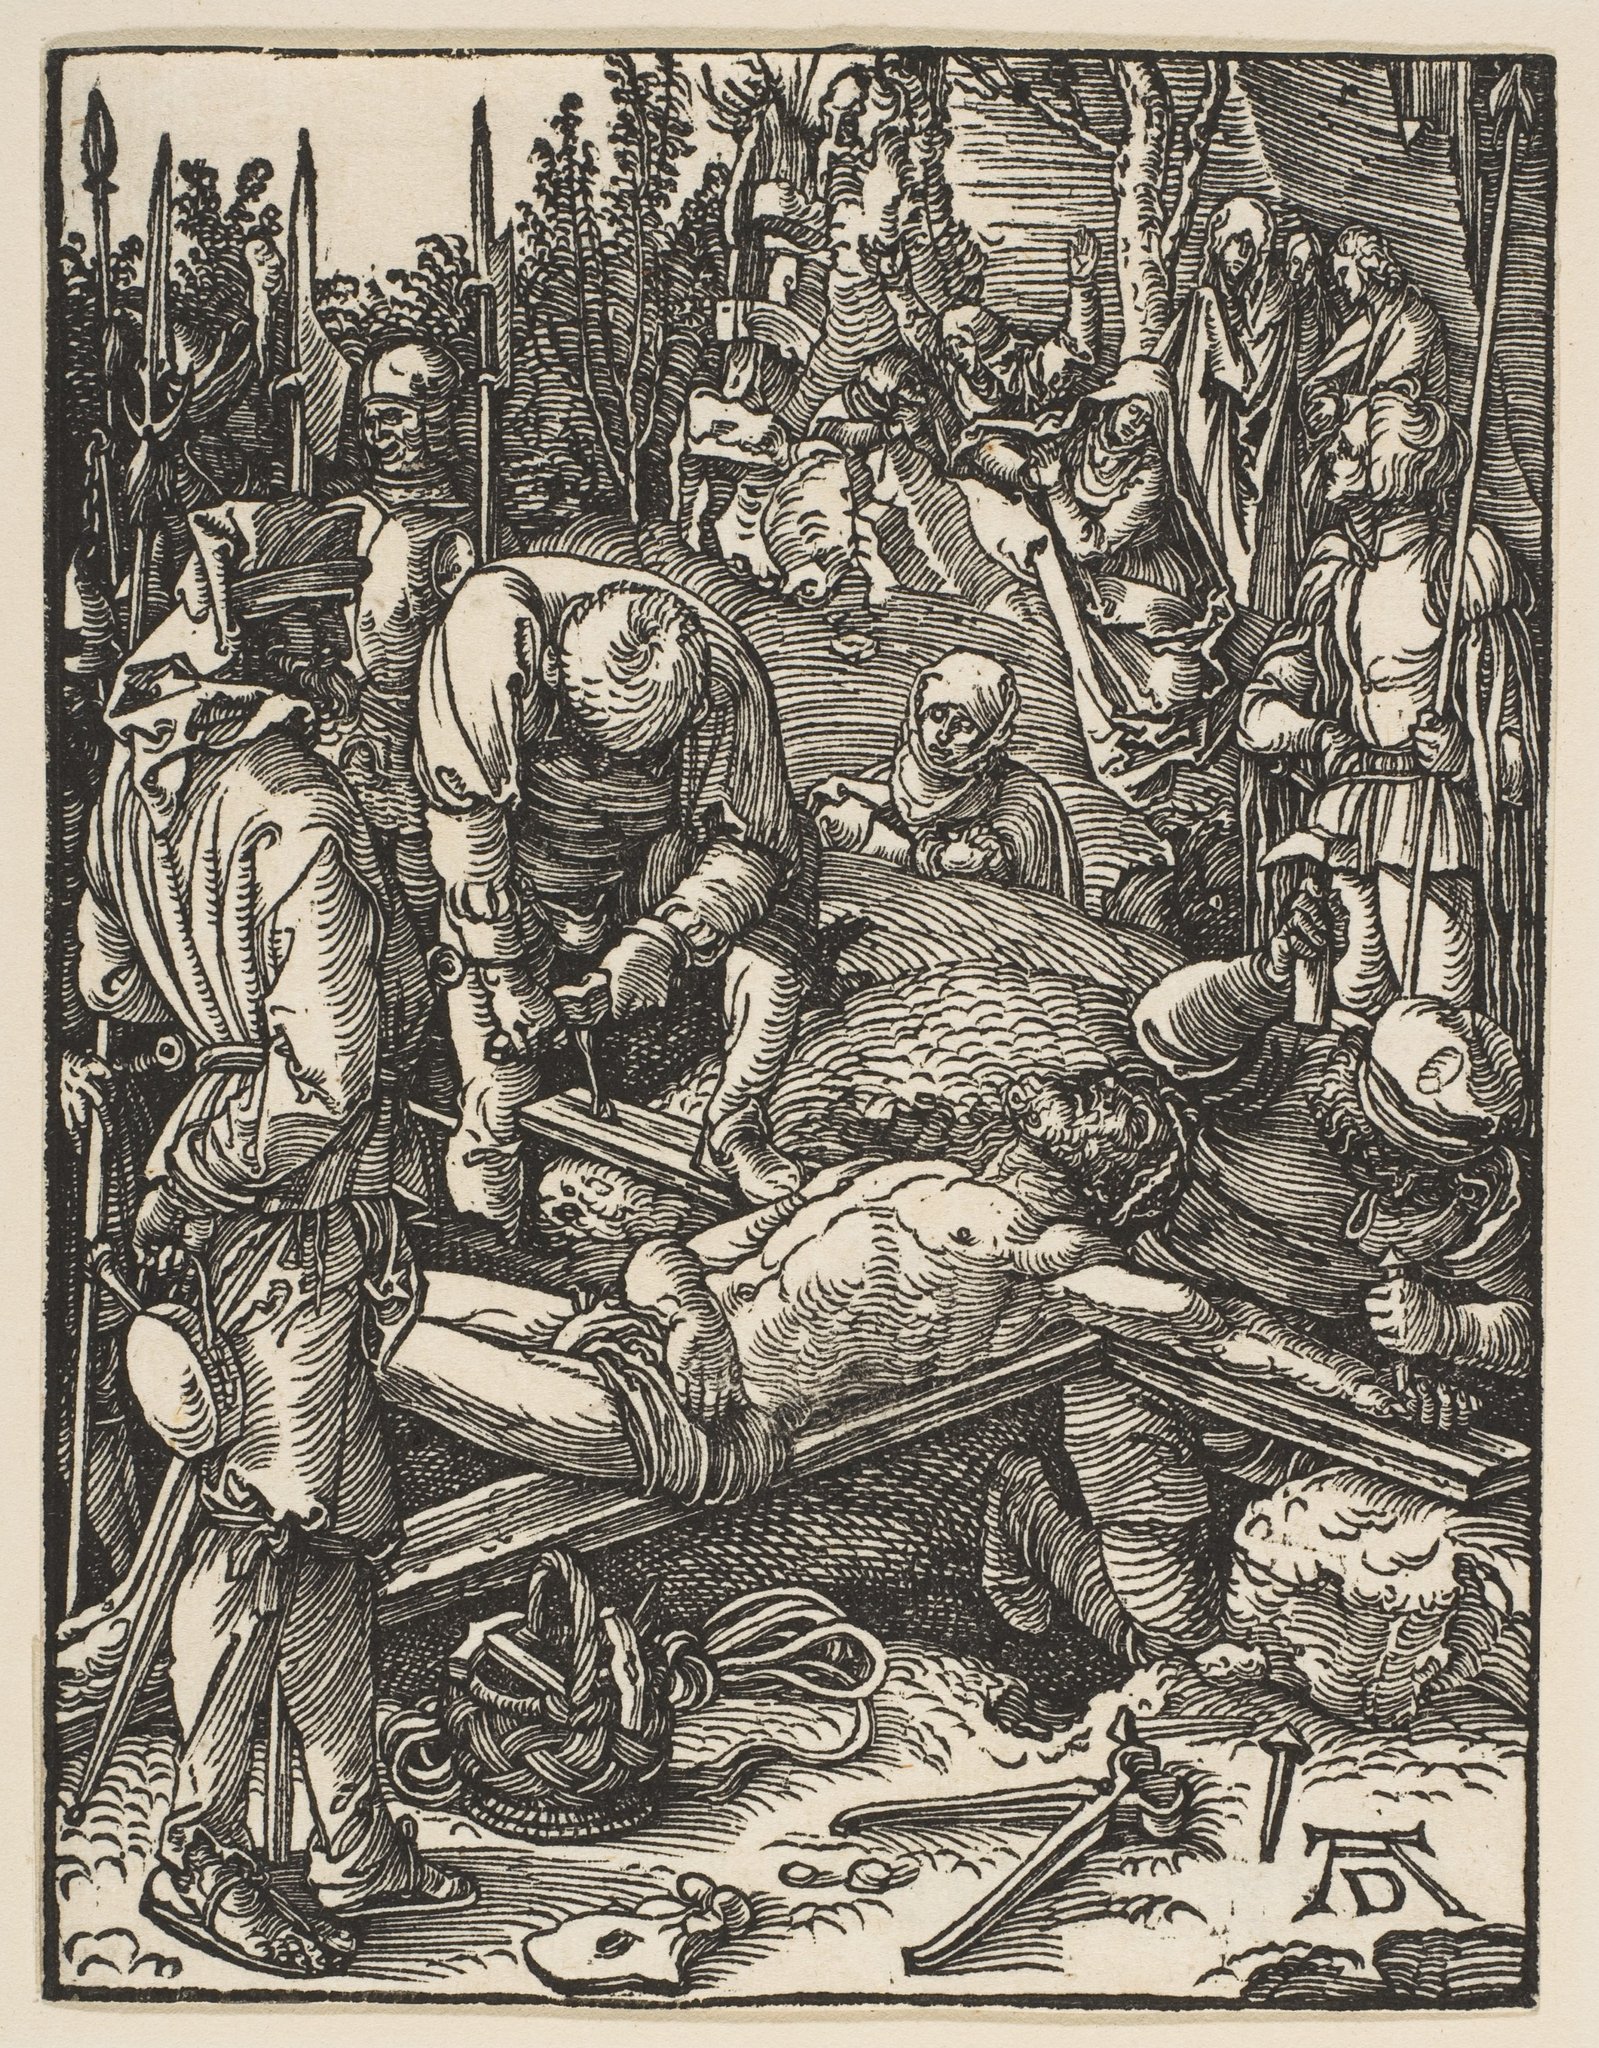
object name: print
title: Christ Nailed to the Cross, from "The Small Passion"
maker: albrecht dürer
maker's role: artist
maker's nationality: german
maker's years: 1471-1528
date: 1509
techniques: woodcut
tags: men,women,christ,cross